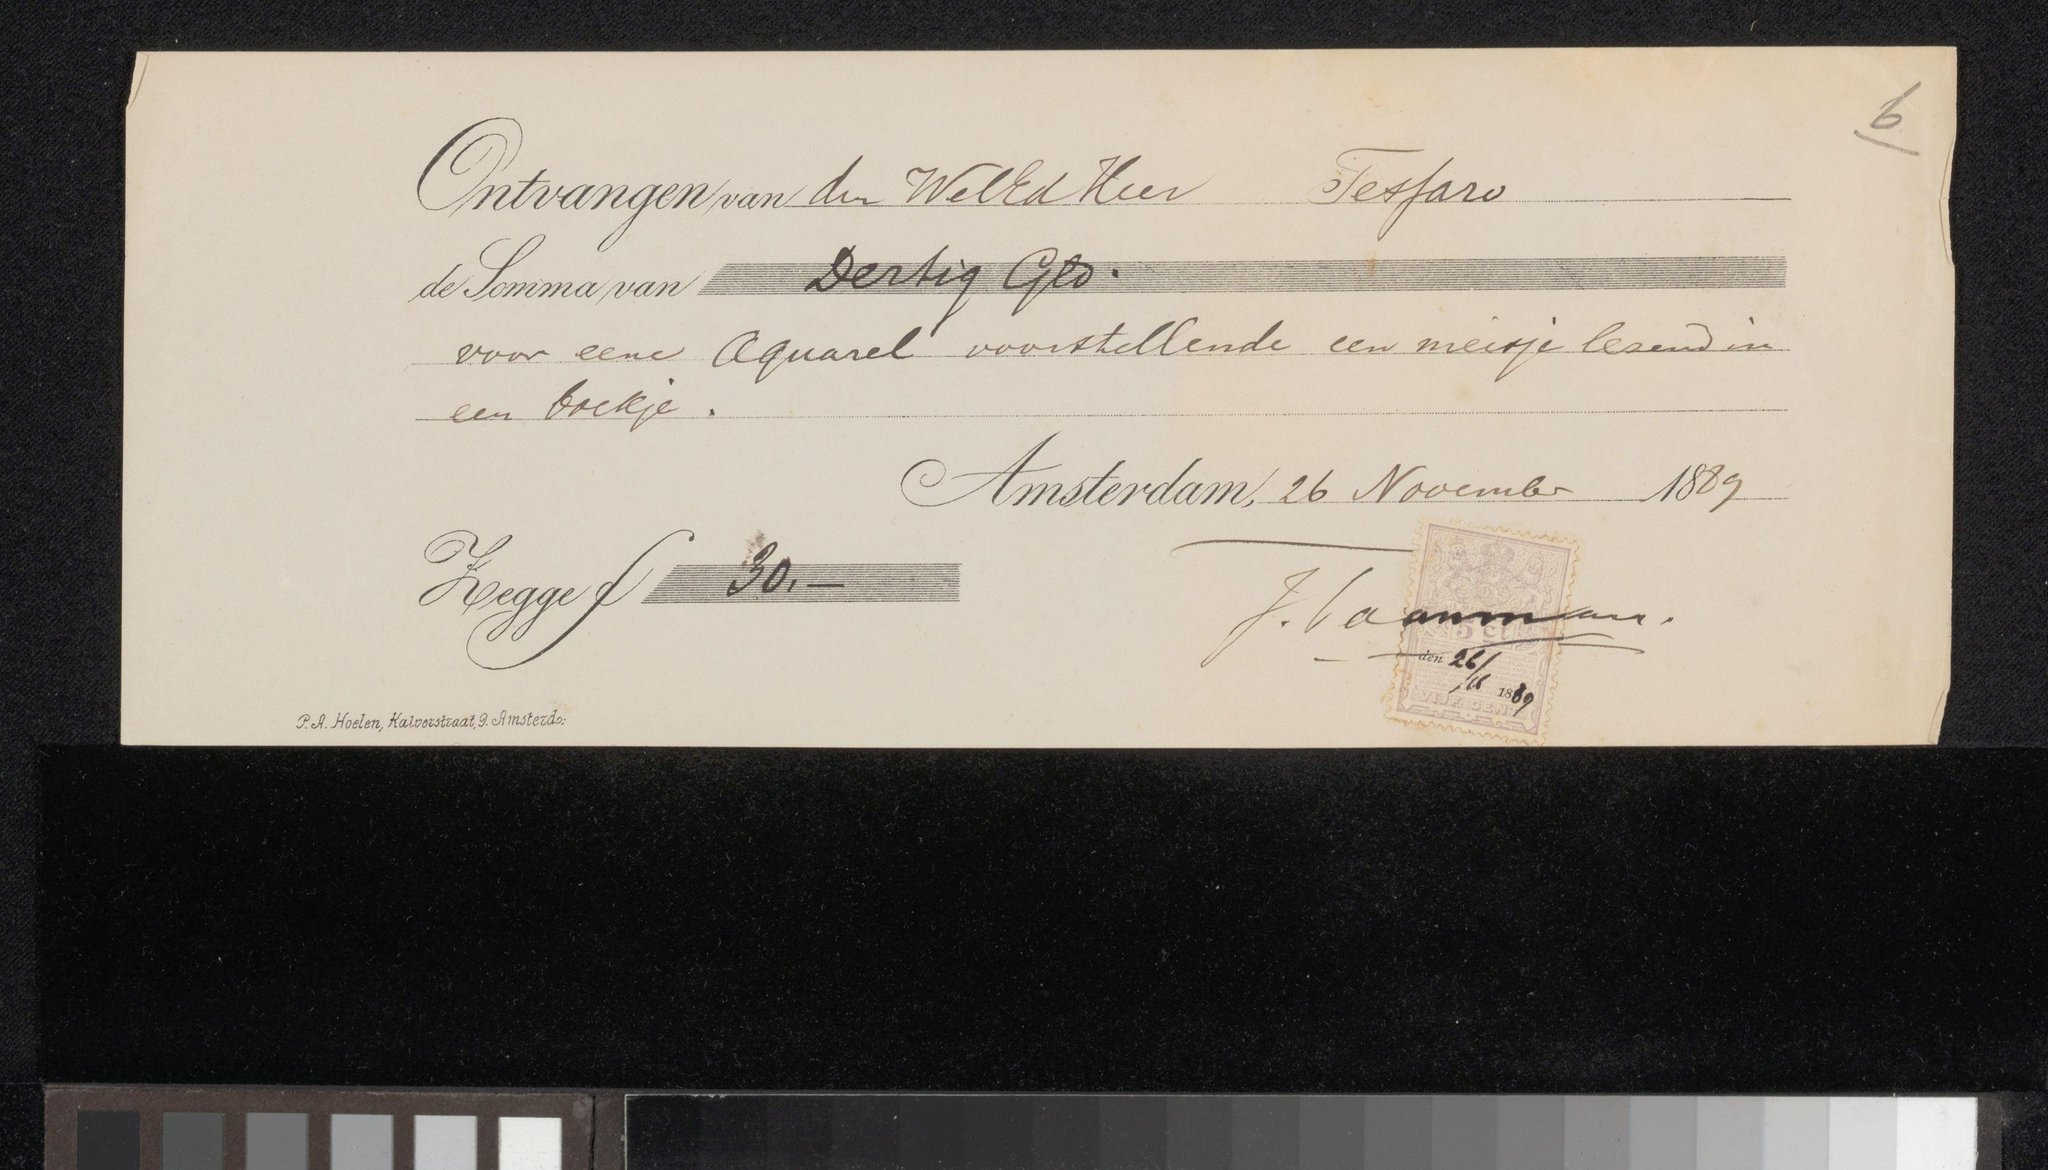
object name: ontvangstbewijs, kwitantie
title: Kwitantie voor Jacob Taanman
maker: jacob taanman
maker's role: draughtsman, print maker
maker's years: 1836-1923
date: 1889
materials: ink, paper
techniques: pen, printing, writing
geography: amsterdam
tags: drawing, money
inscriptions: collector's mark: Lugt 2233